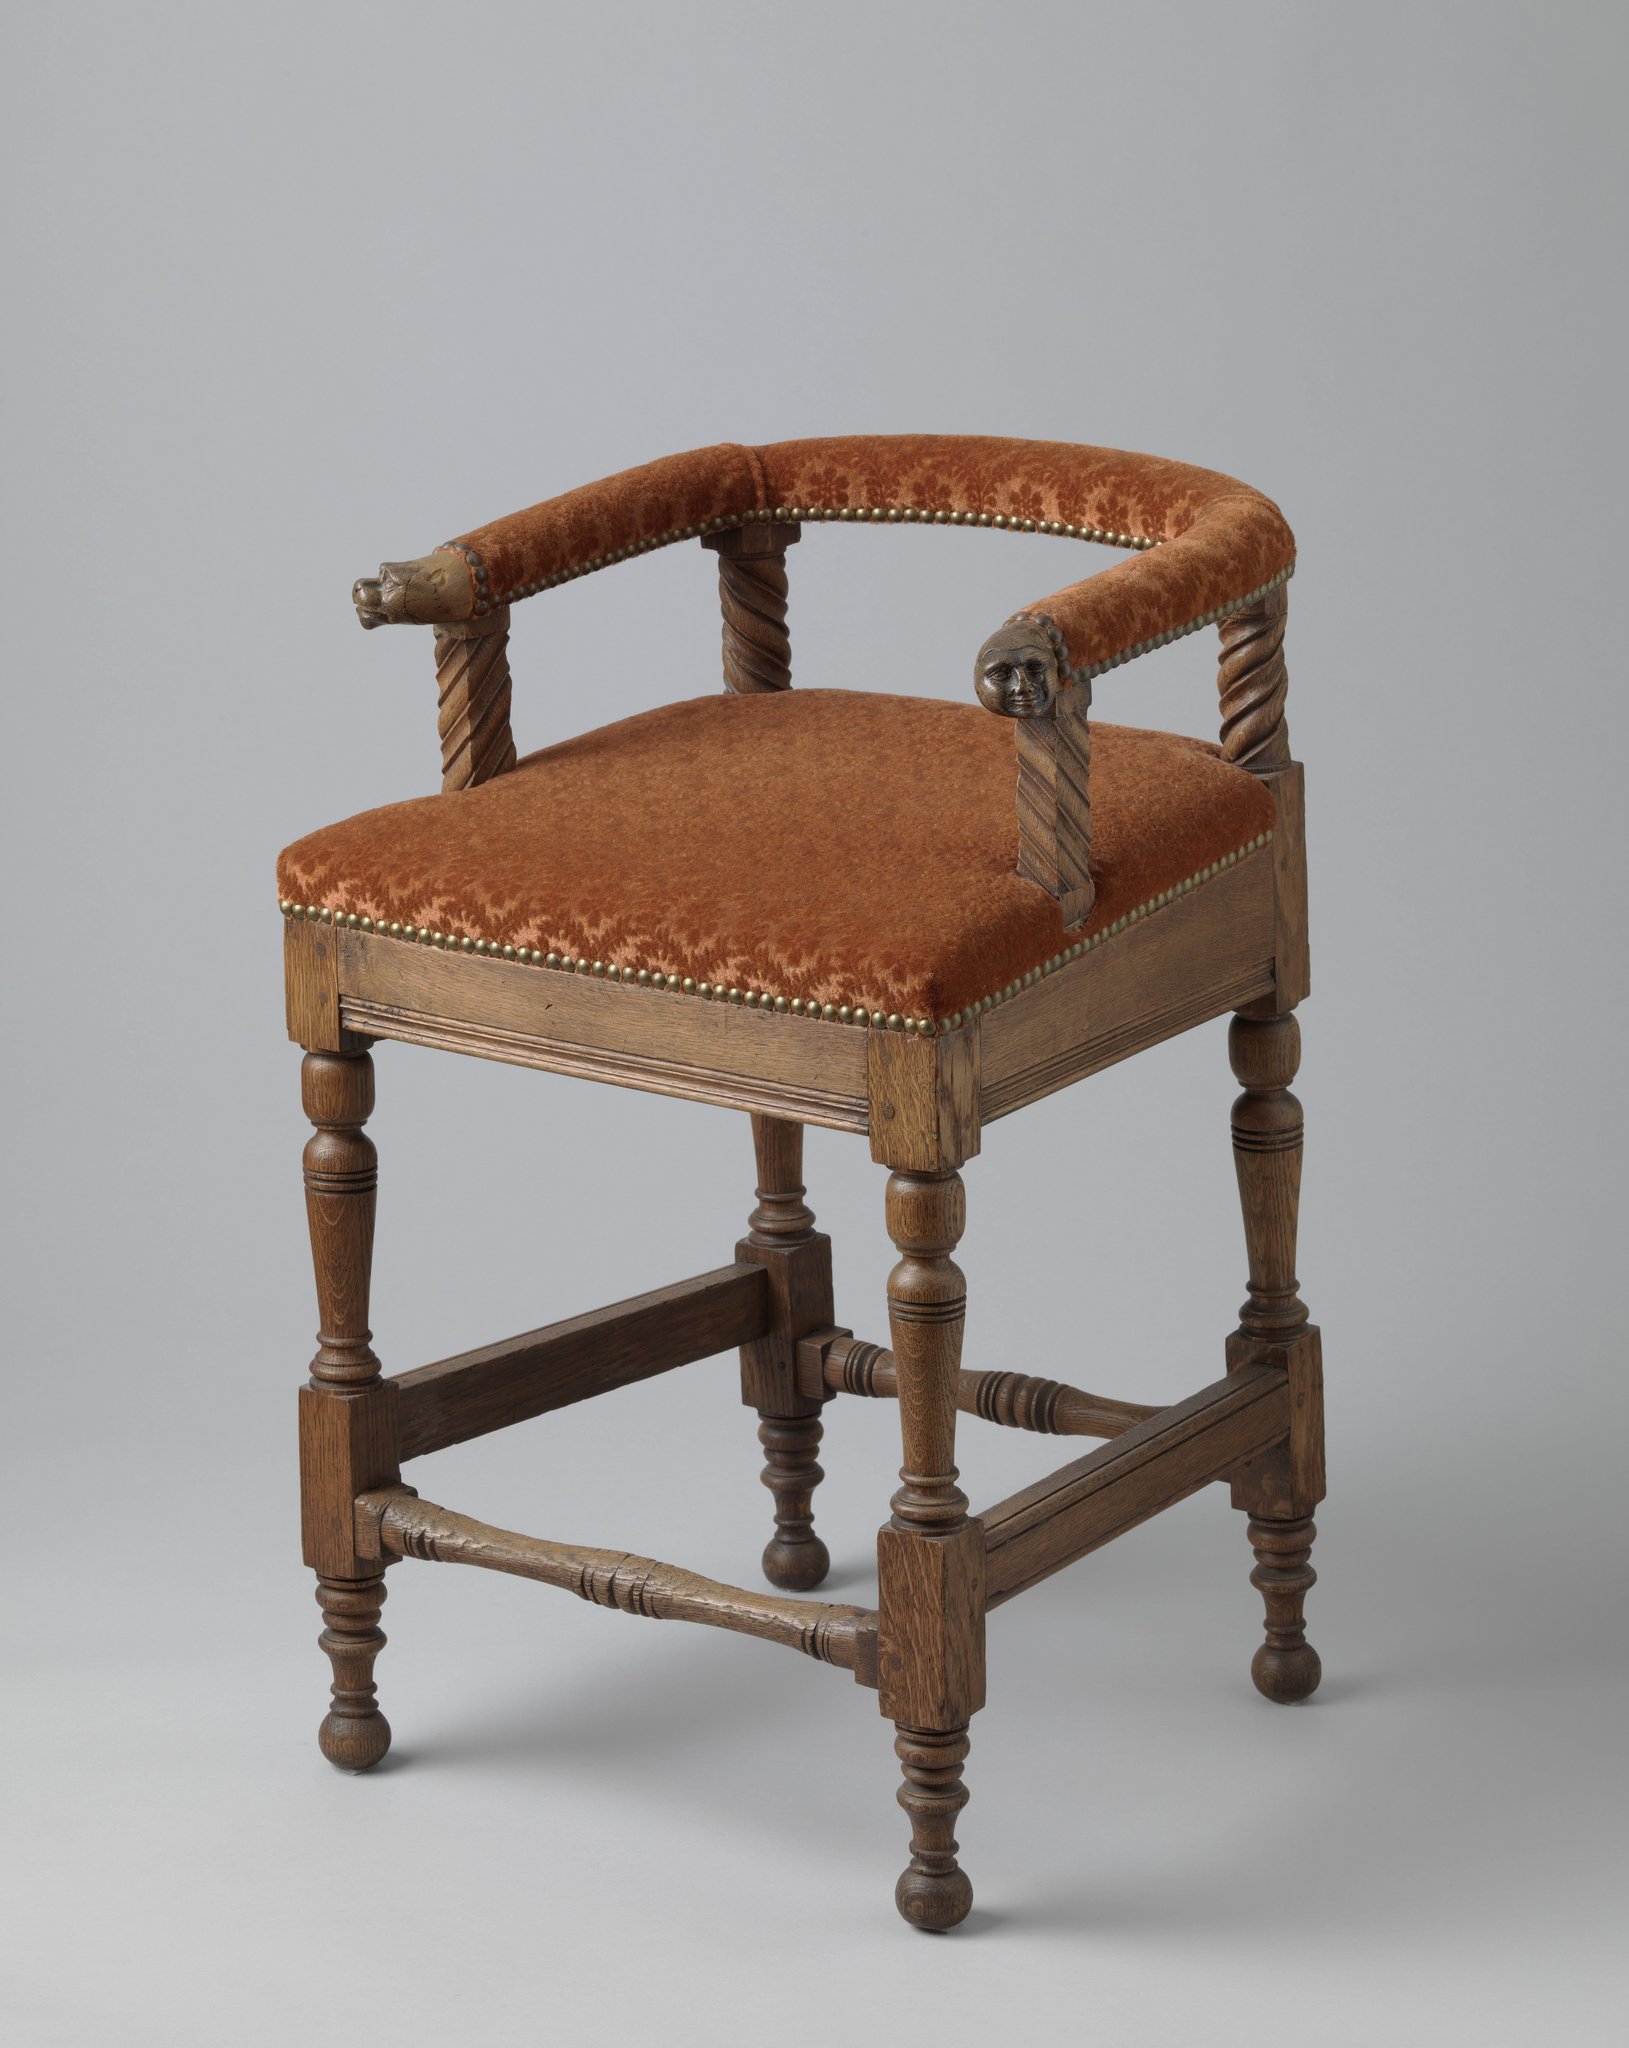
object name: seating furniture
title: Stoel met lage arm- en zijleuningen en met armleggers die eindigen in een groteskenkop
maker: pierre joseph hubert cuypers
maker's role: draughtsman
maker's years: 1827-1921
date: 1880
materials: textile, wood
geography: roermond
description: Stoel met lage arm- en zijleuningen en met armleggers die eindigen in een groteskenkop. Bekleed met rood trijp.